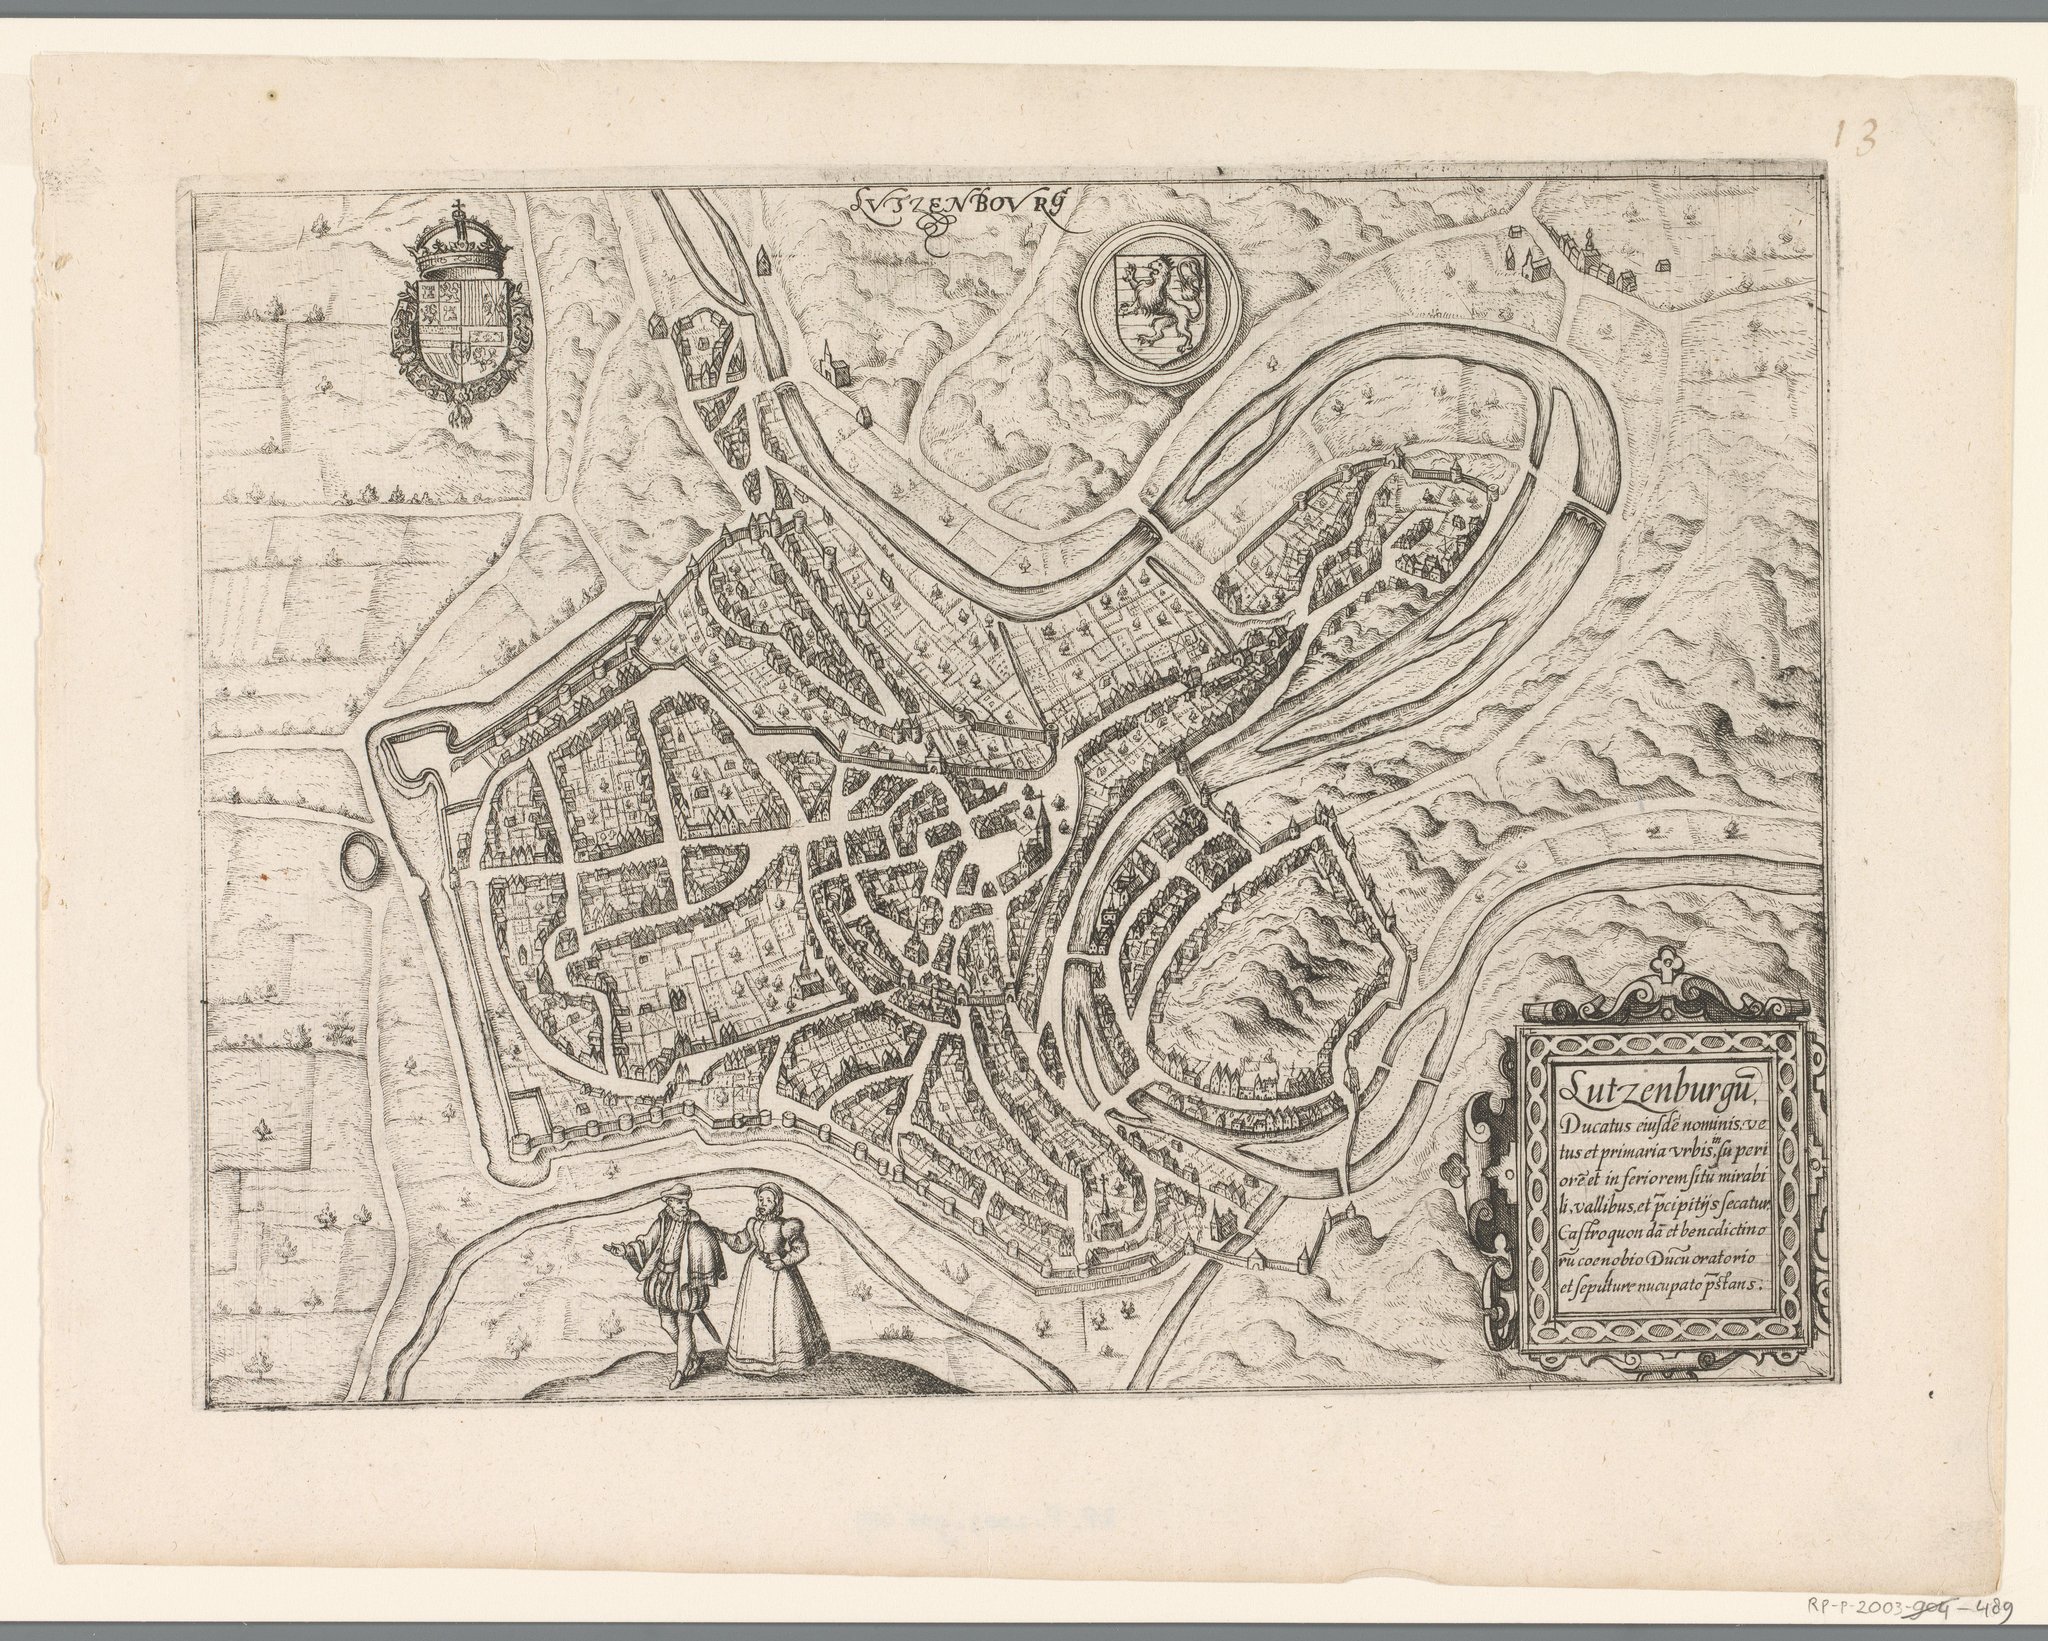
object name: area plan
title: Plattegrond van de stad Luxemburg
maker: Anonymous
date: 1607-1609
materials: paper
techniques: etching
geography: southern netherlands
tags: maps of cities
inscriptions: number: ‘13’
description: Plattegrond van de stad Luxemburg (Luxembourg). Linksboven het wapen van de koning van Spanje, rechtsboven het wapen van het hertogdom Luxemburg. Rechtsonder een cartouche met een opschrift in het Latijn. Op de voorgrond een man en een vrouw. Onderdeel van de verzameling kaarten genomen uit een latere editie van: Descrittione di tutti i Paesi Bassi van Lodovico Guicciardini.